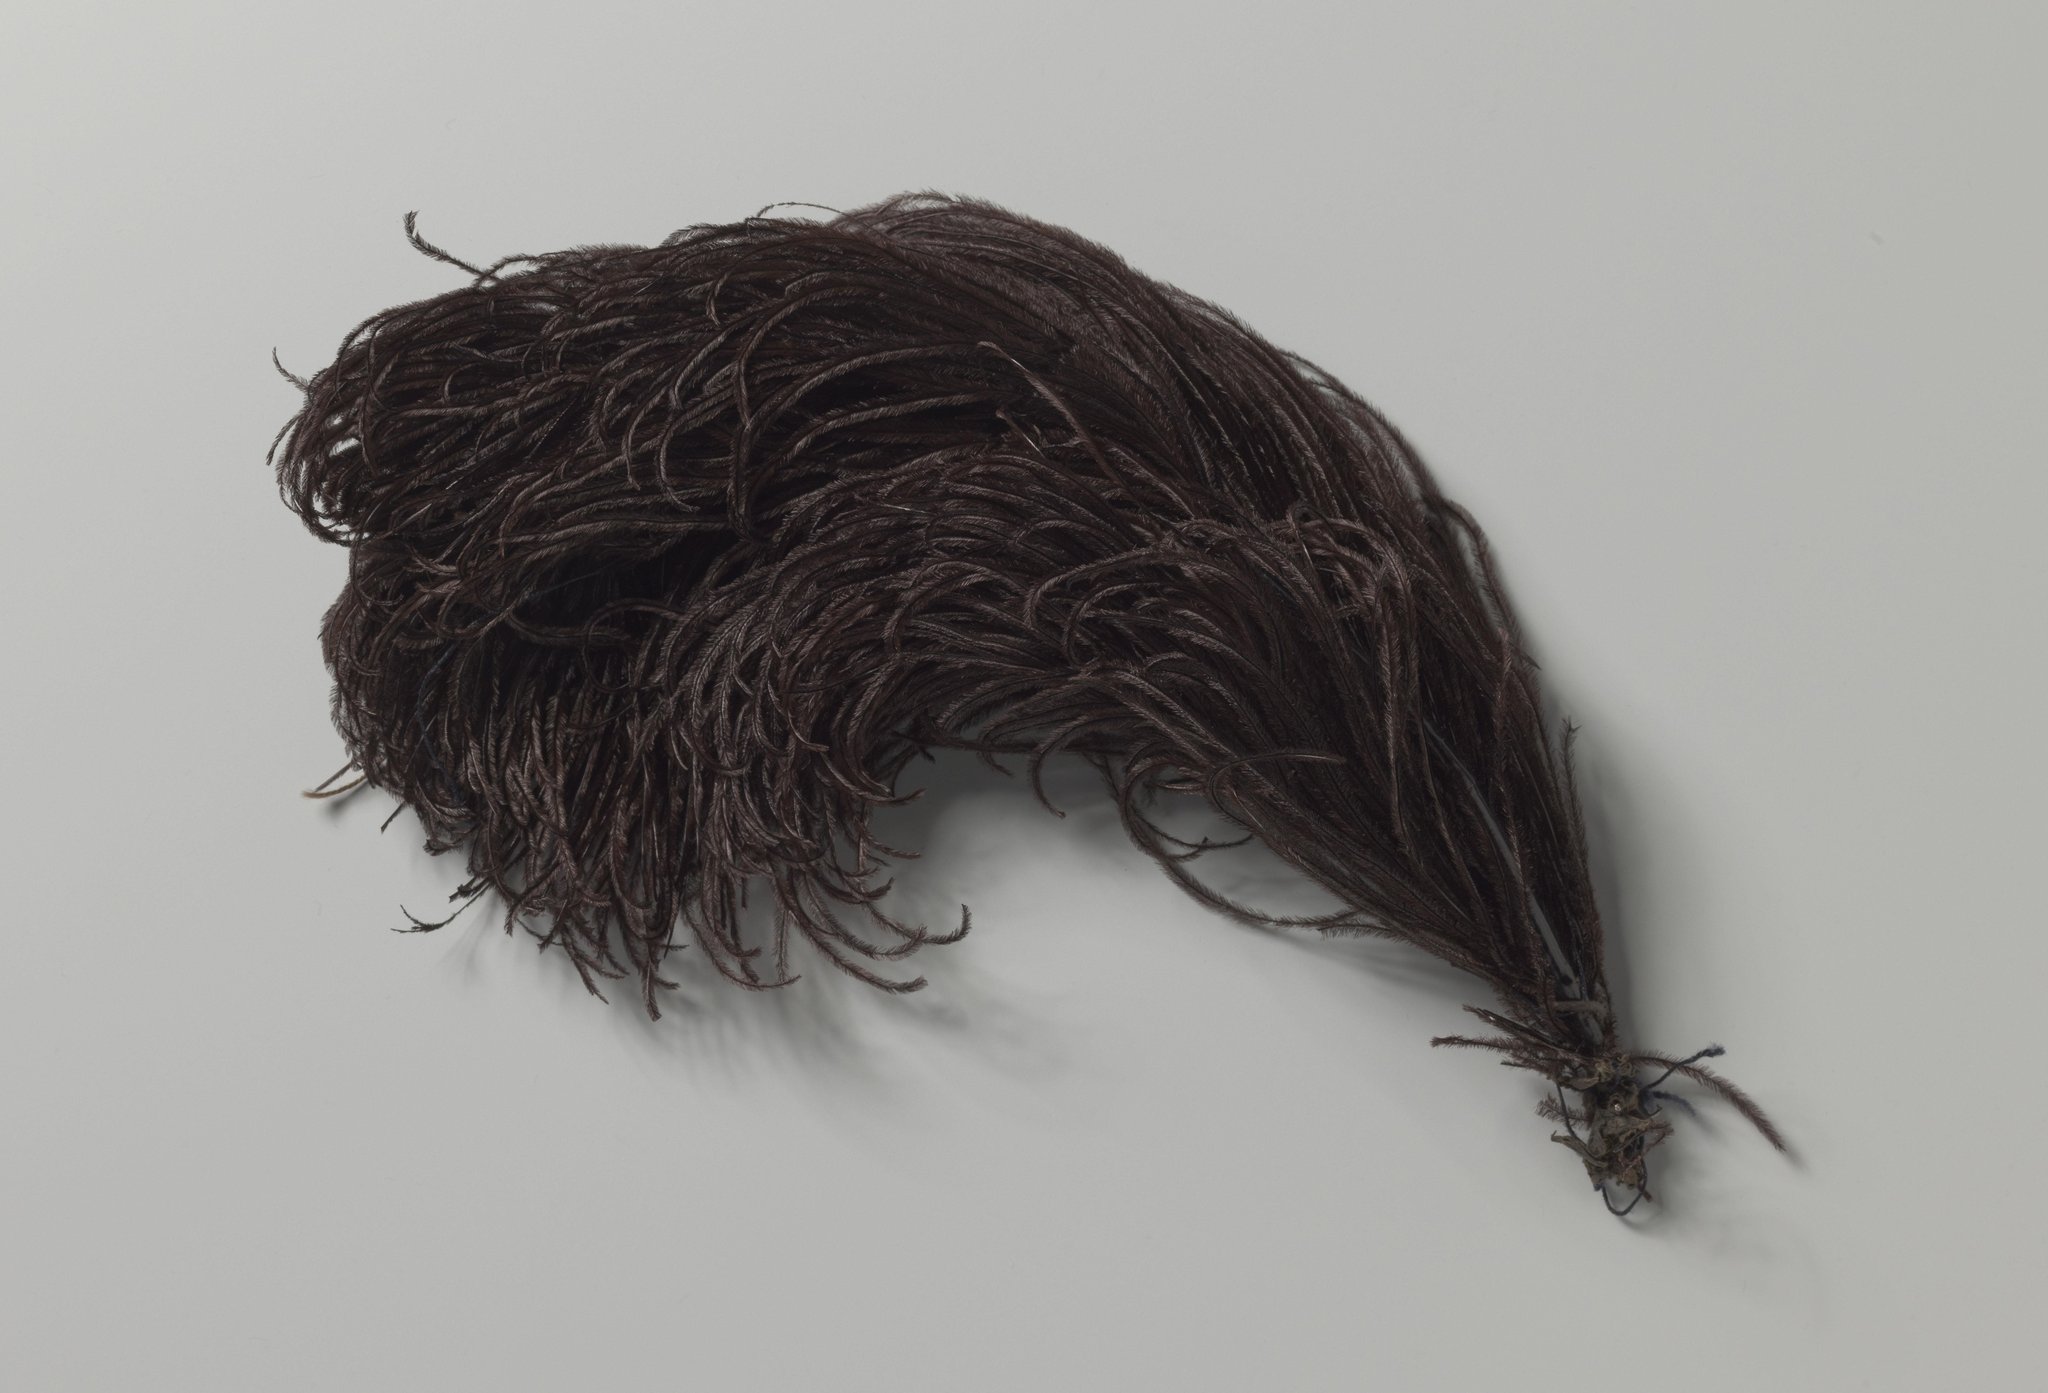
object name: womenswear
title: Toef donkerbruine struisveren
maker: Anonymous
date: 1880-1925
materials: metal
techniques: painting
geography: western europe